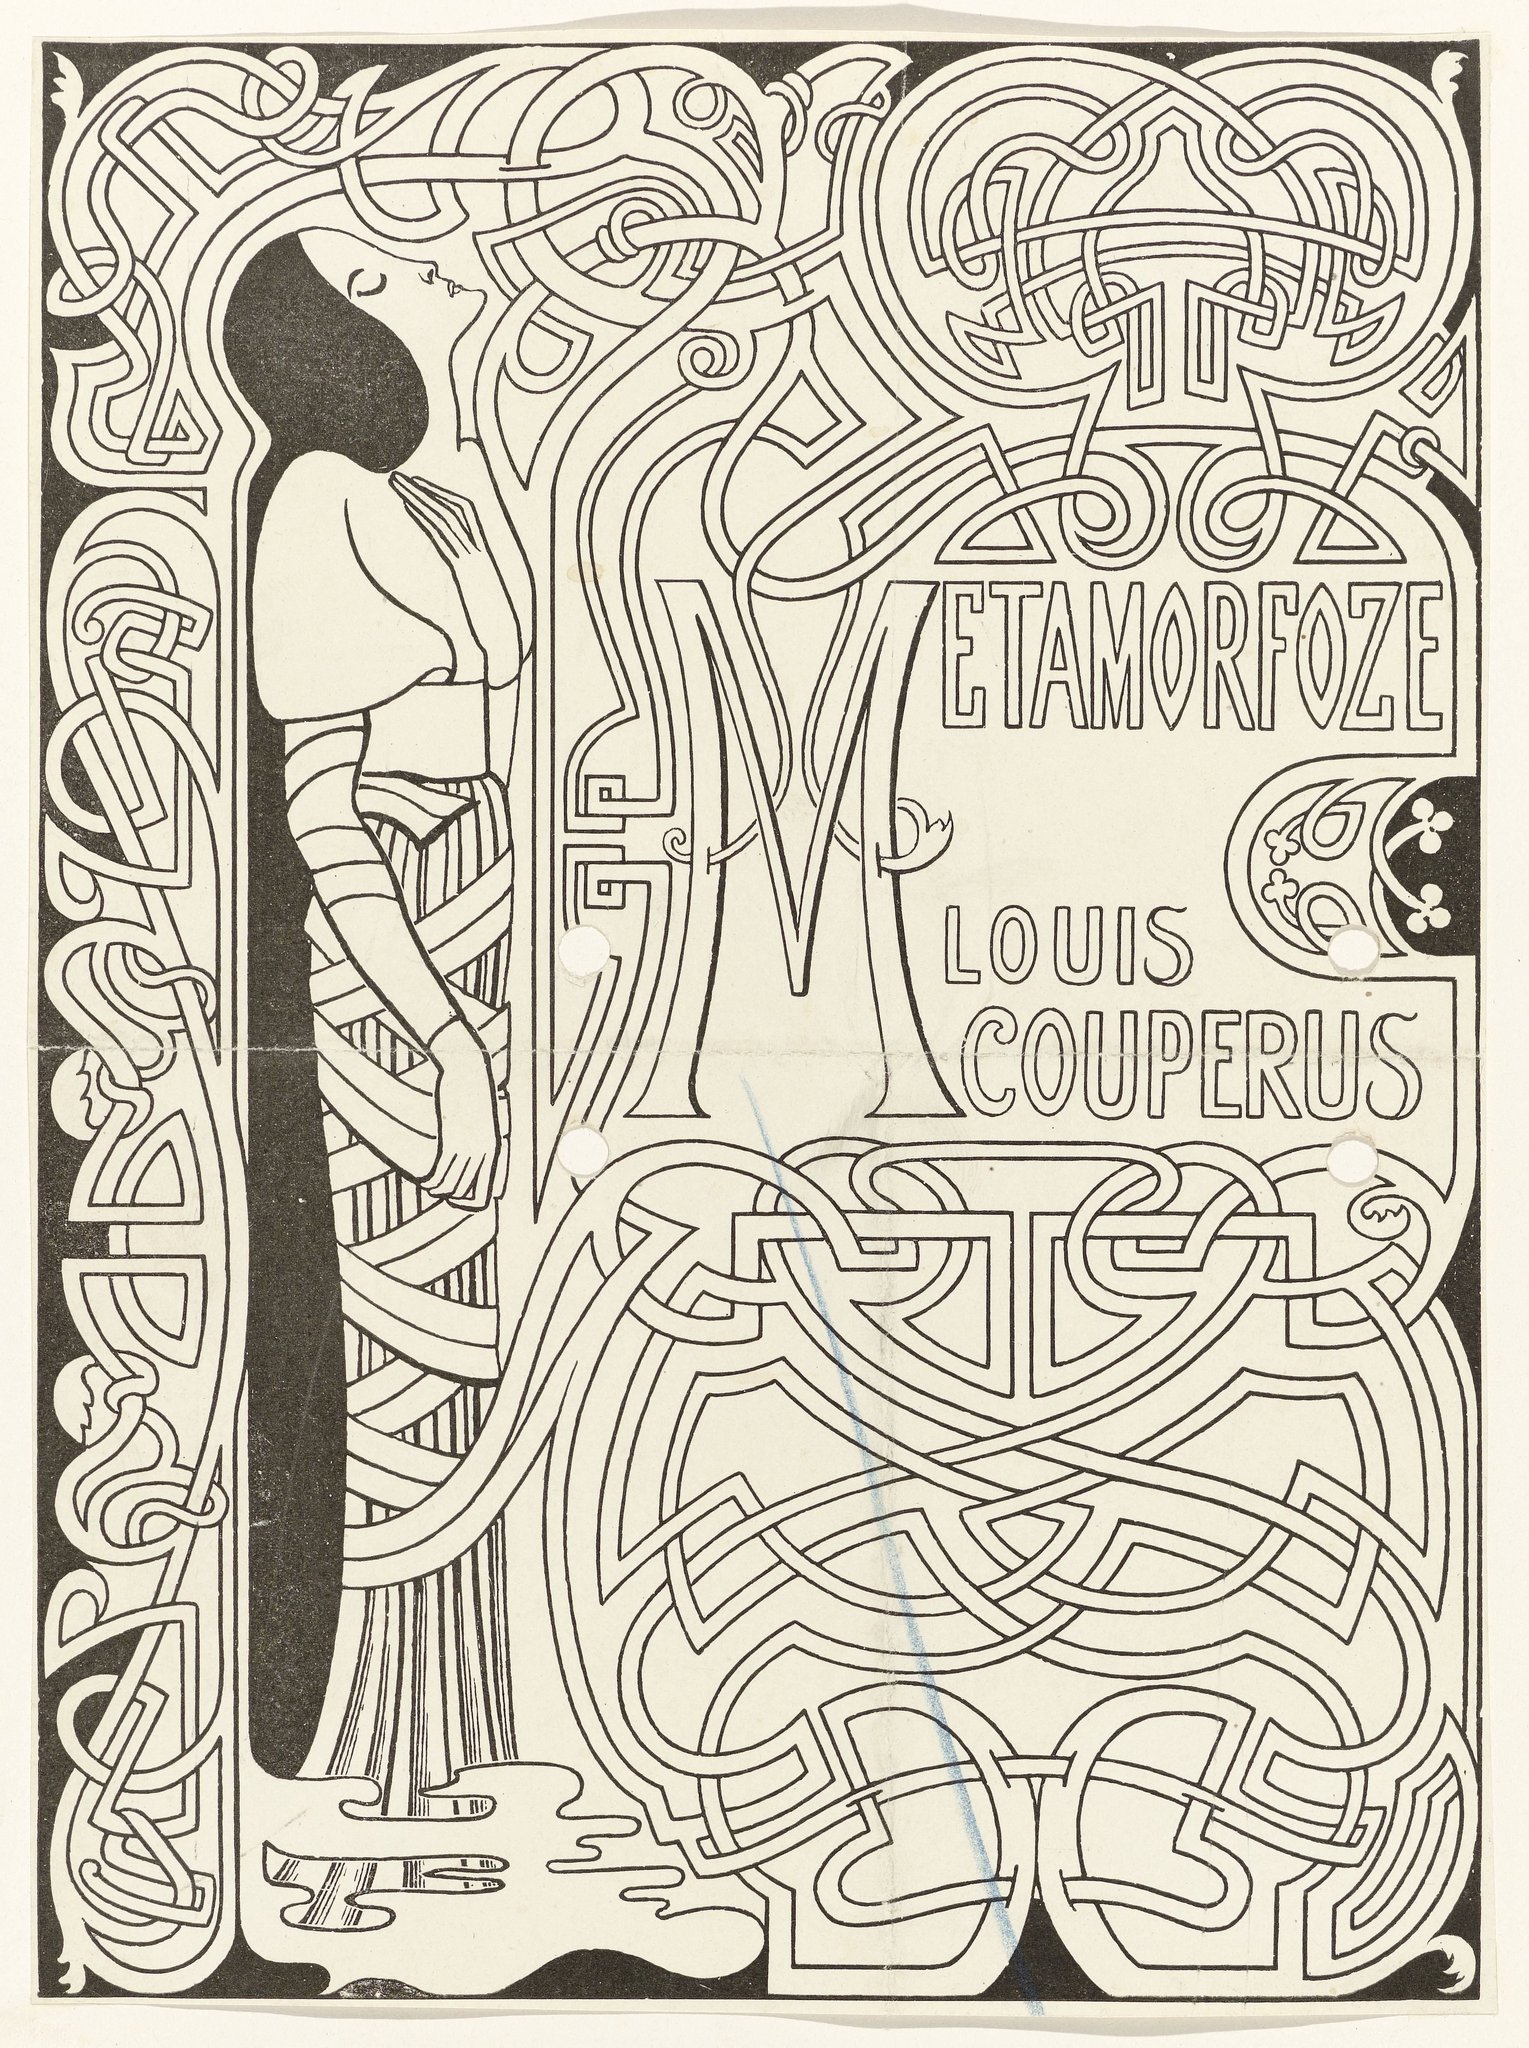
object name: text sheet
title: Boekband Metamorfoze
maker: jan toorop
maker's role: draughtsman, painter, print maker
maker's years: 1858-1928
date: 1868-1928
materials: paper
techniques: letterpress printing